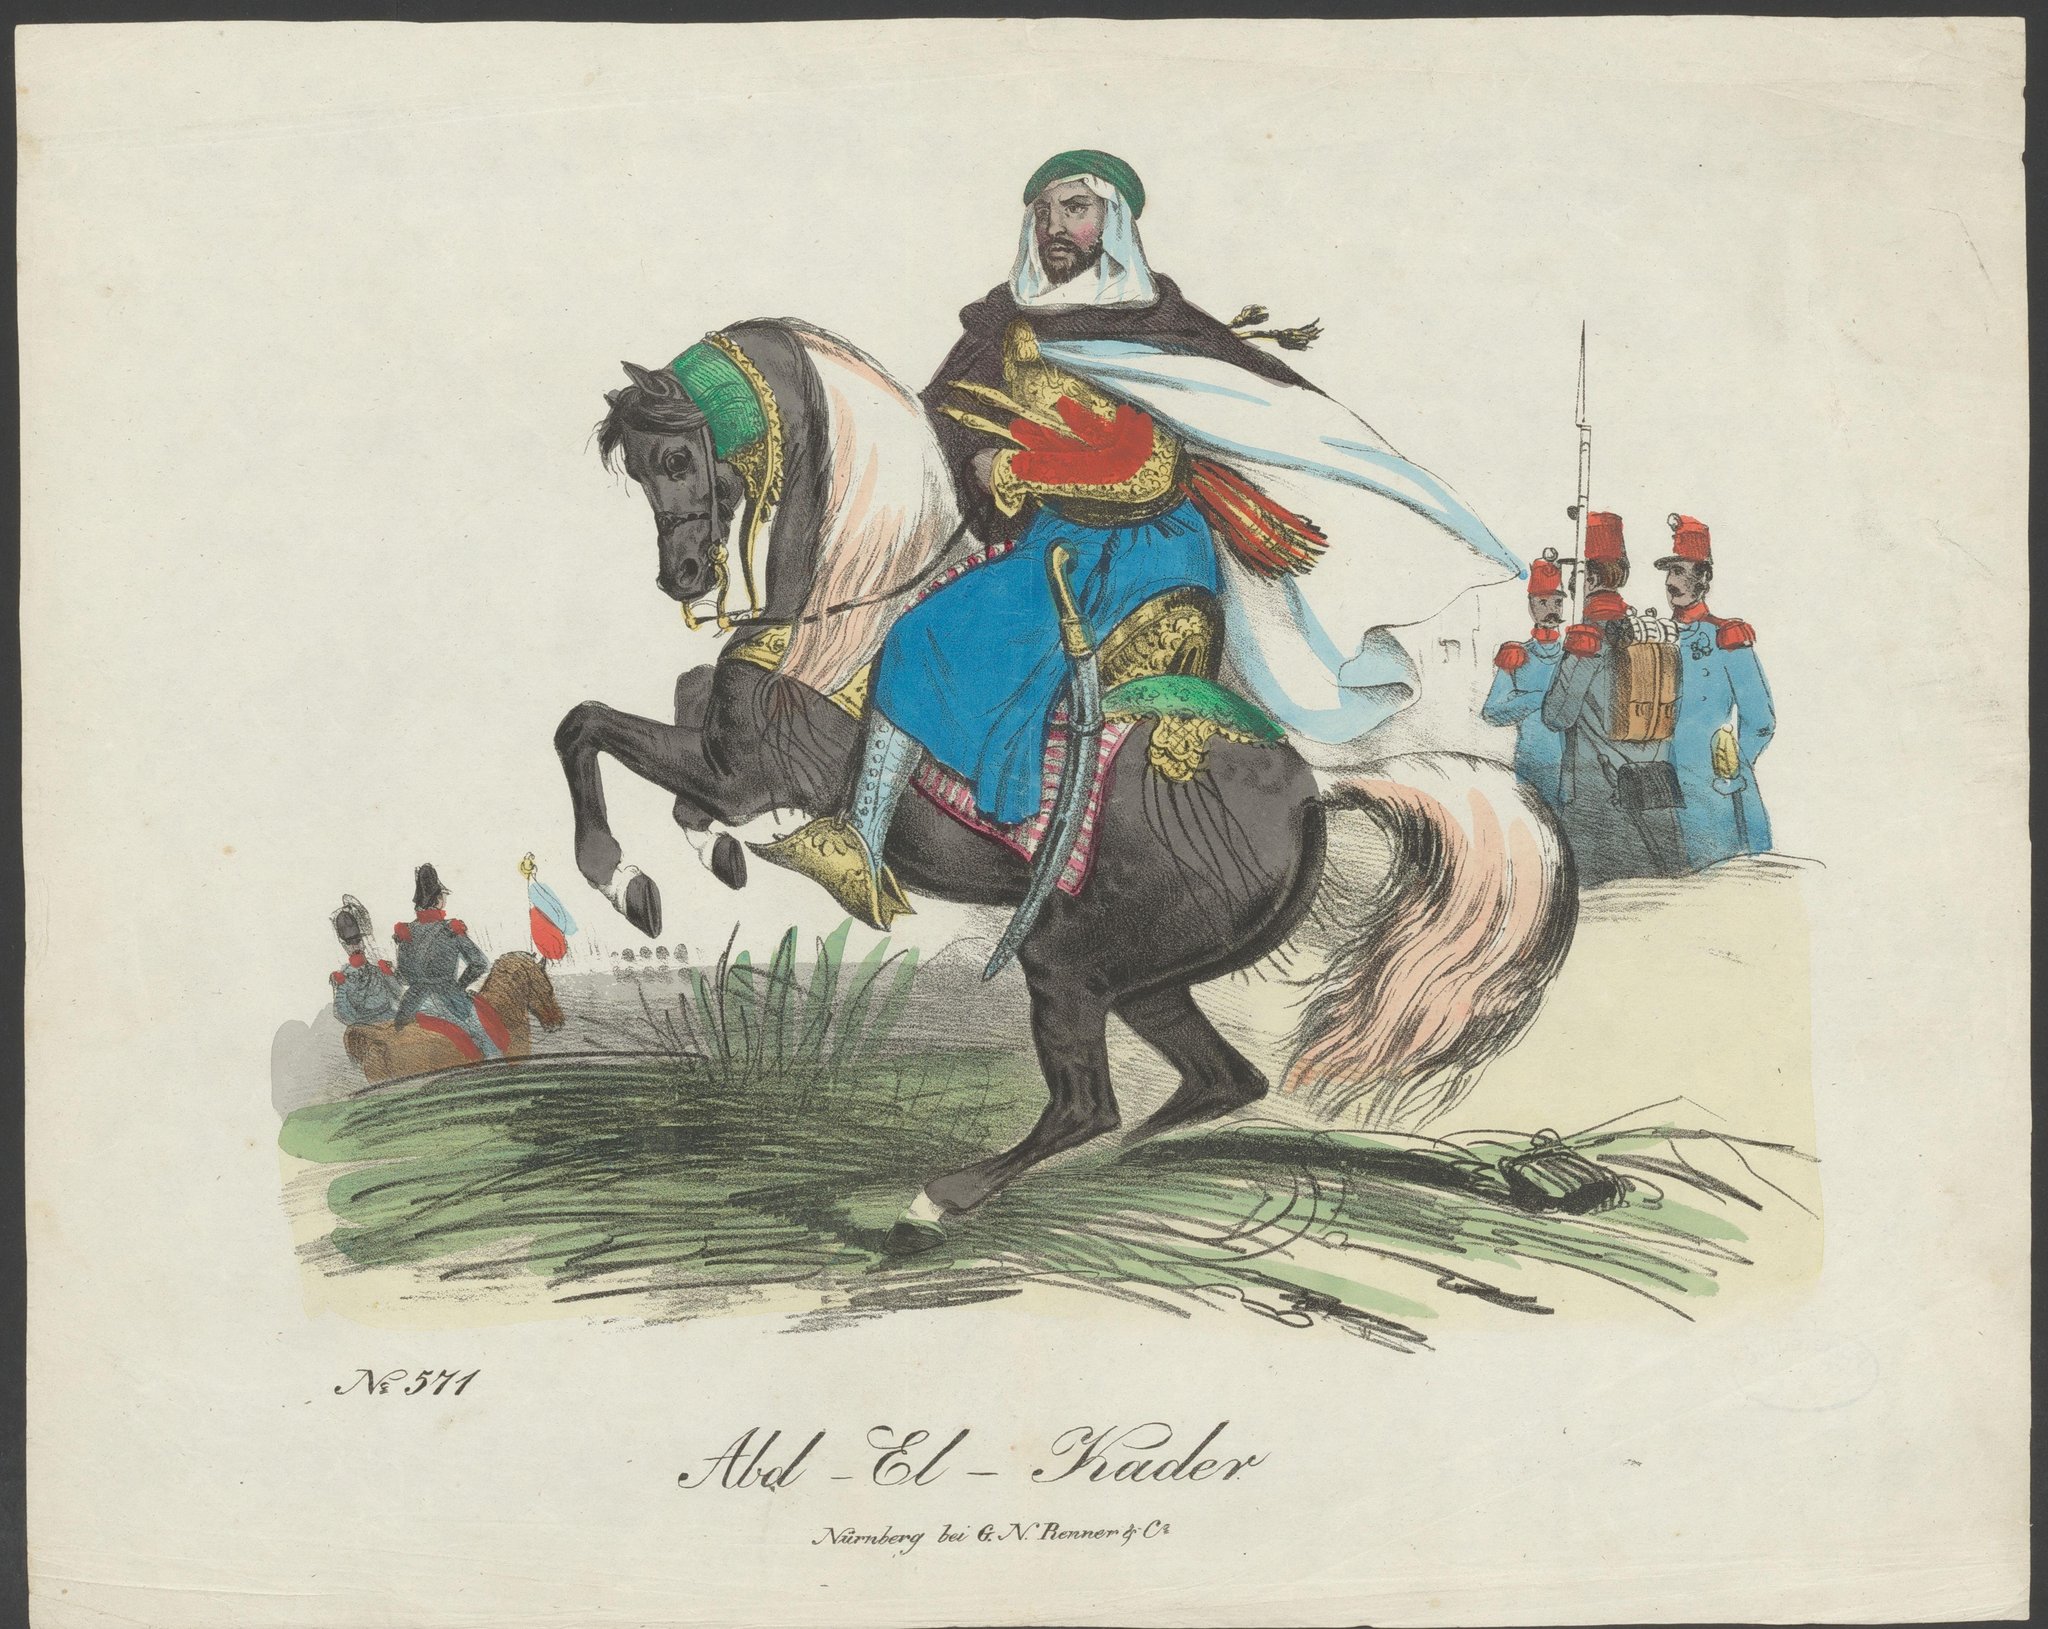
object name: print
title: Abd al-Kader, bey van Mascara op een steigerend paard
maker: Anonymous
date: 1837-1868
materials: paper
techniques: hand coloring, lithograph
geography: nuremberg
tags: military service, knight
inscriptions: collector's mark: Lugt 1641, stamp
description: Linksonder genummerd: No. 571. Onderwerpsrubrieken binnen de Atlas Zeden en Gewoonten: Zeden en Gewoonten in Engeren Zin, Des menschen beging, midden en einde, Kinderleven – Kinderspel en Kinderprenten.